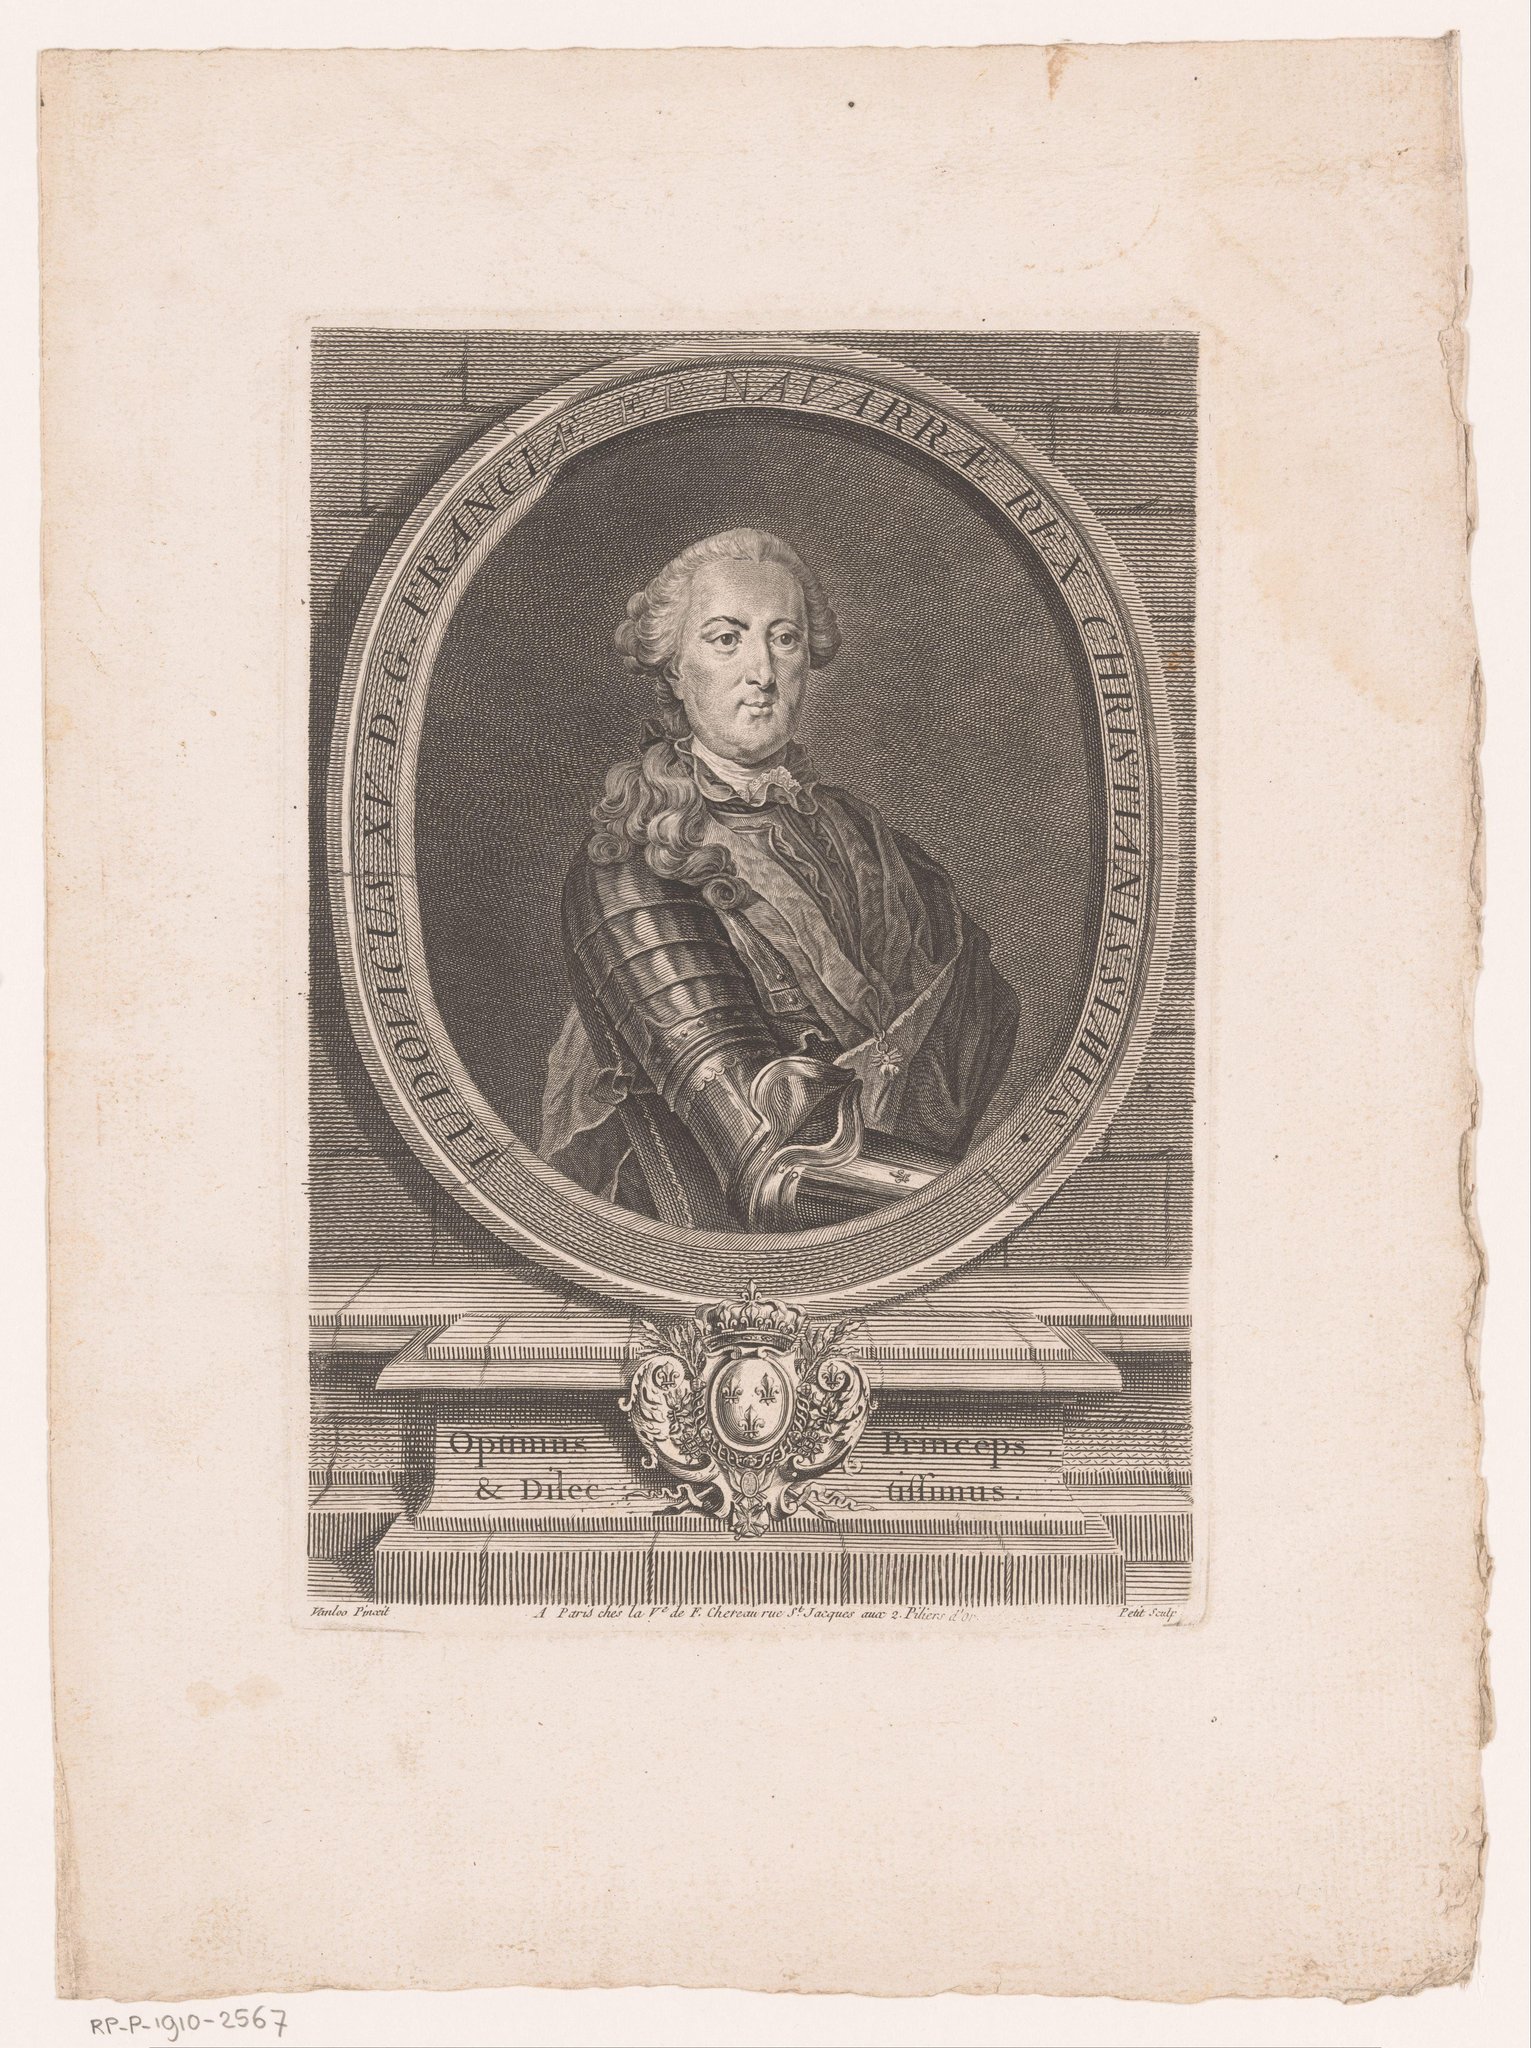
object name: print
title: Portret van Lodewijk XV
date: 1729-1755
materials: paper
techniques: engraving, etching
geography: paris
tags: louis xv of france, historical persons, king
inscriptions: collector's mark: Lugt 2228